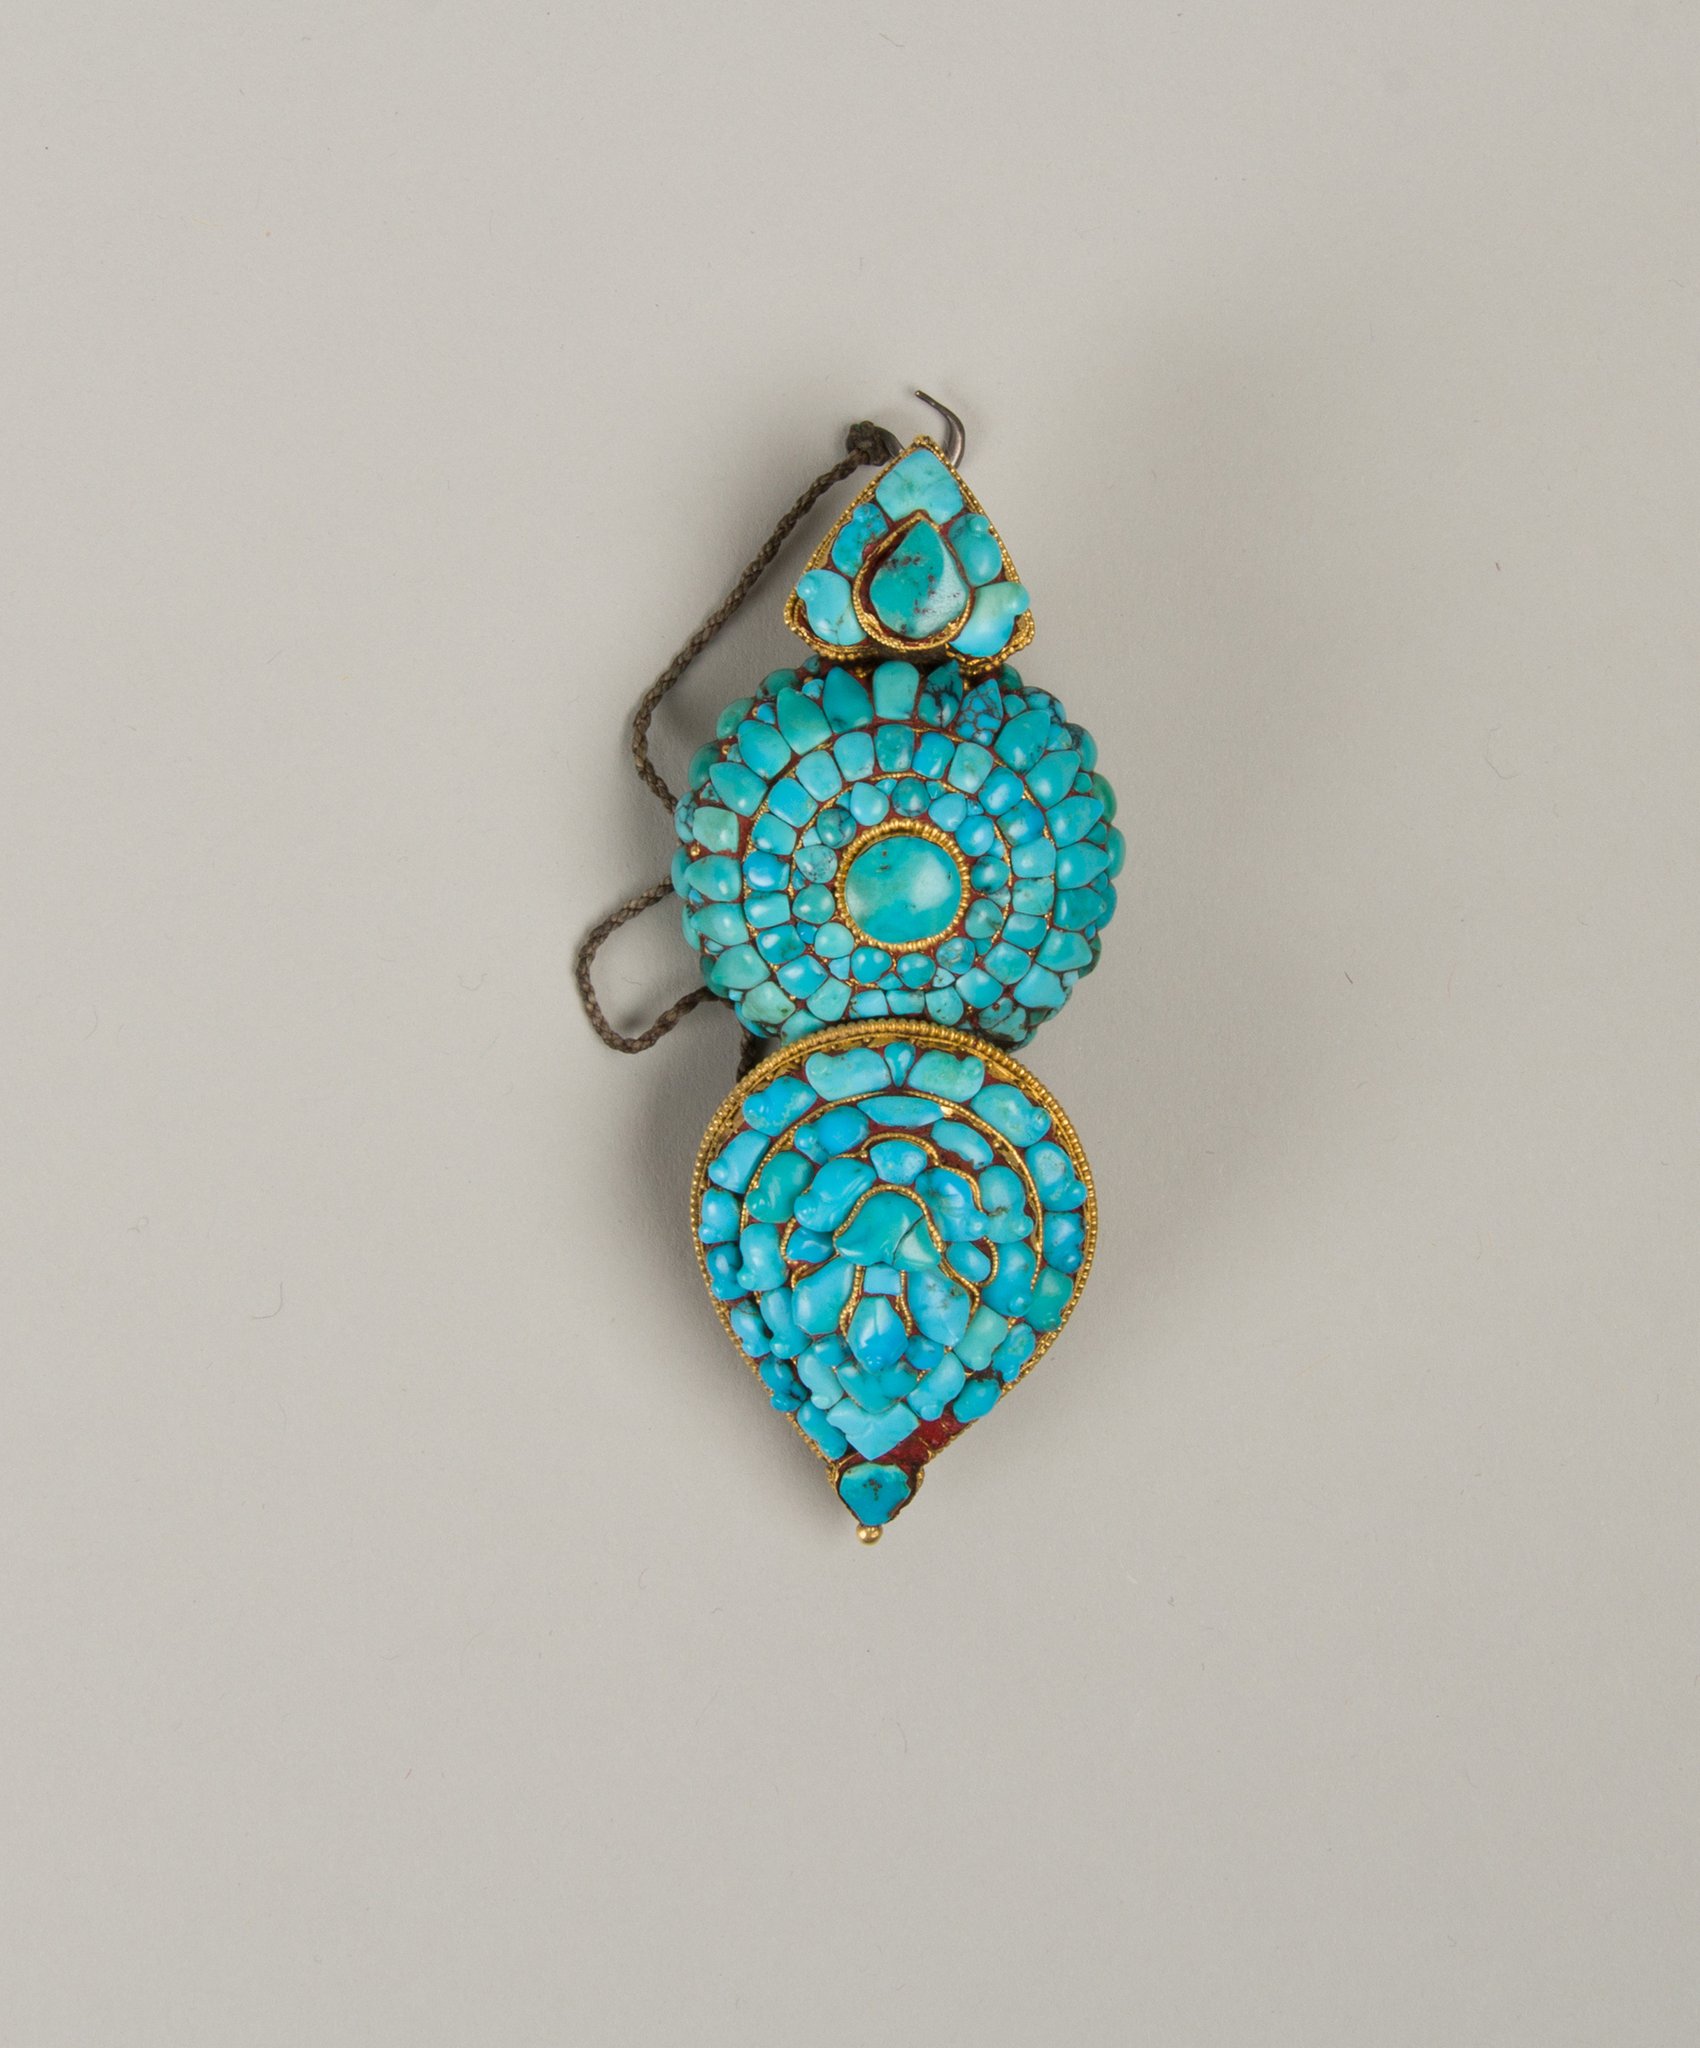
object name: earring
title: Woman's Earring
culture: tibet, lhasa area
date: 1801-1933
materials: gold